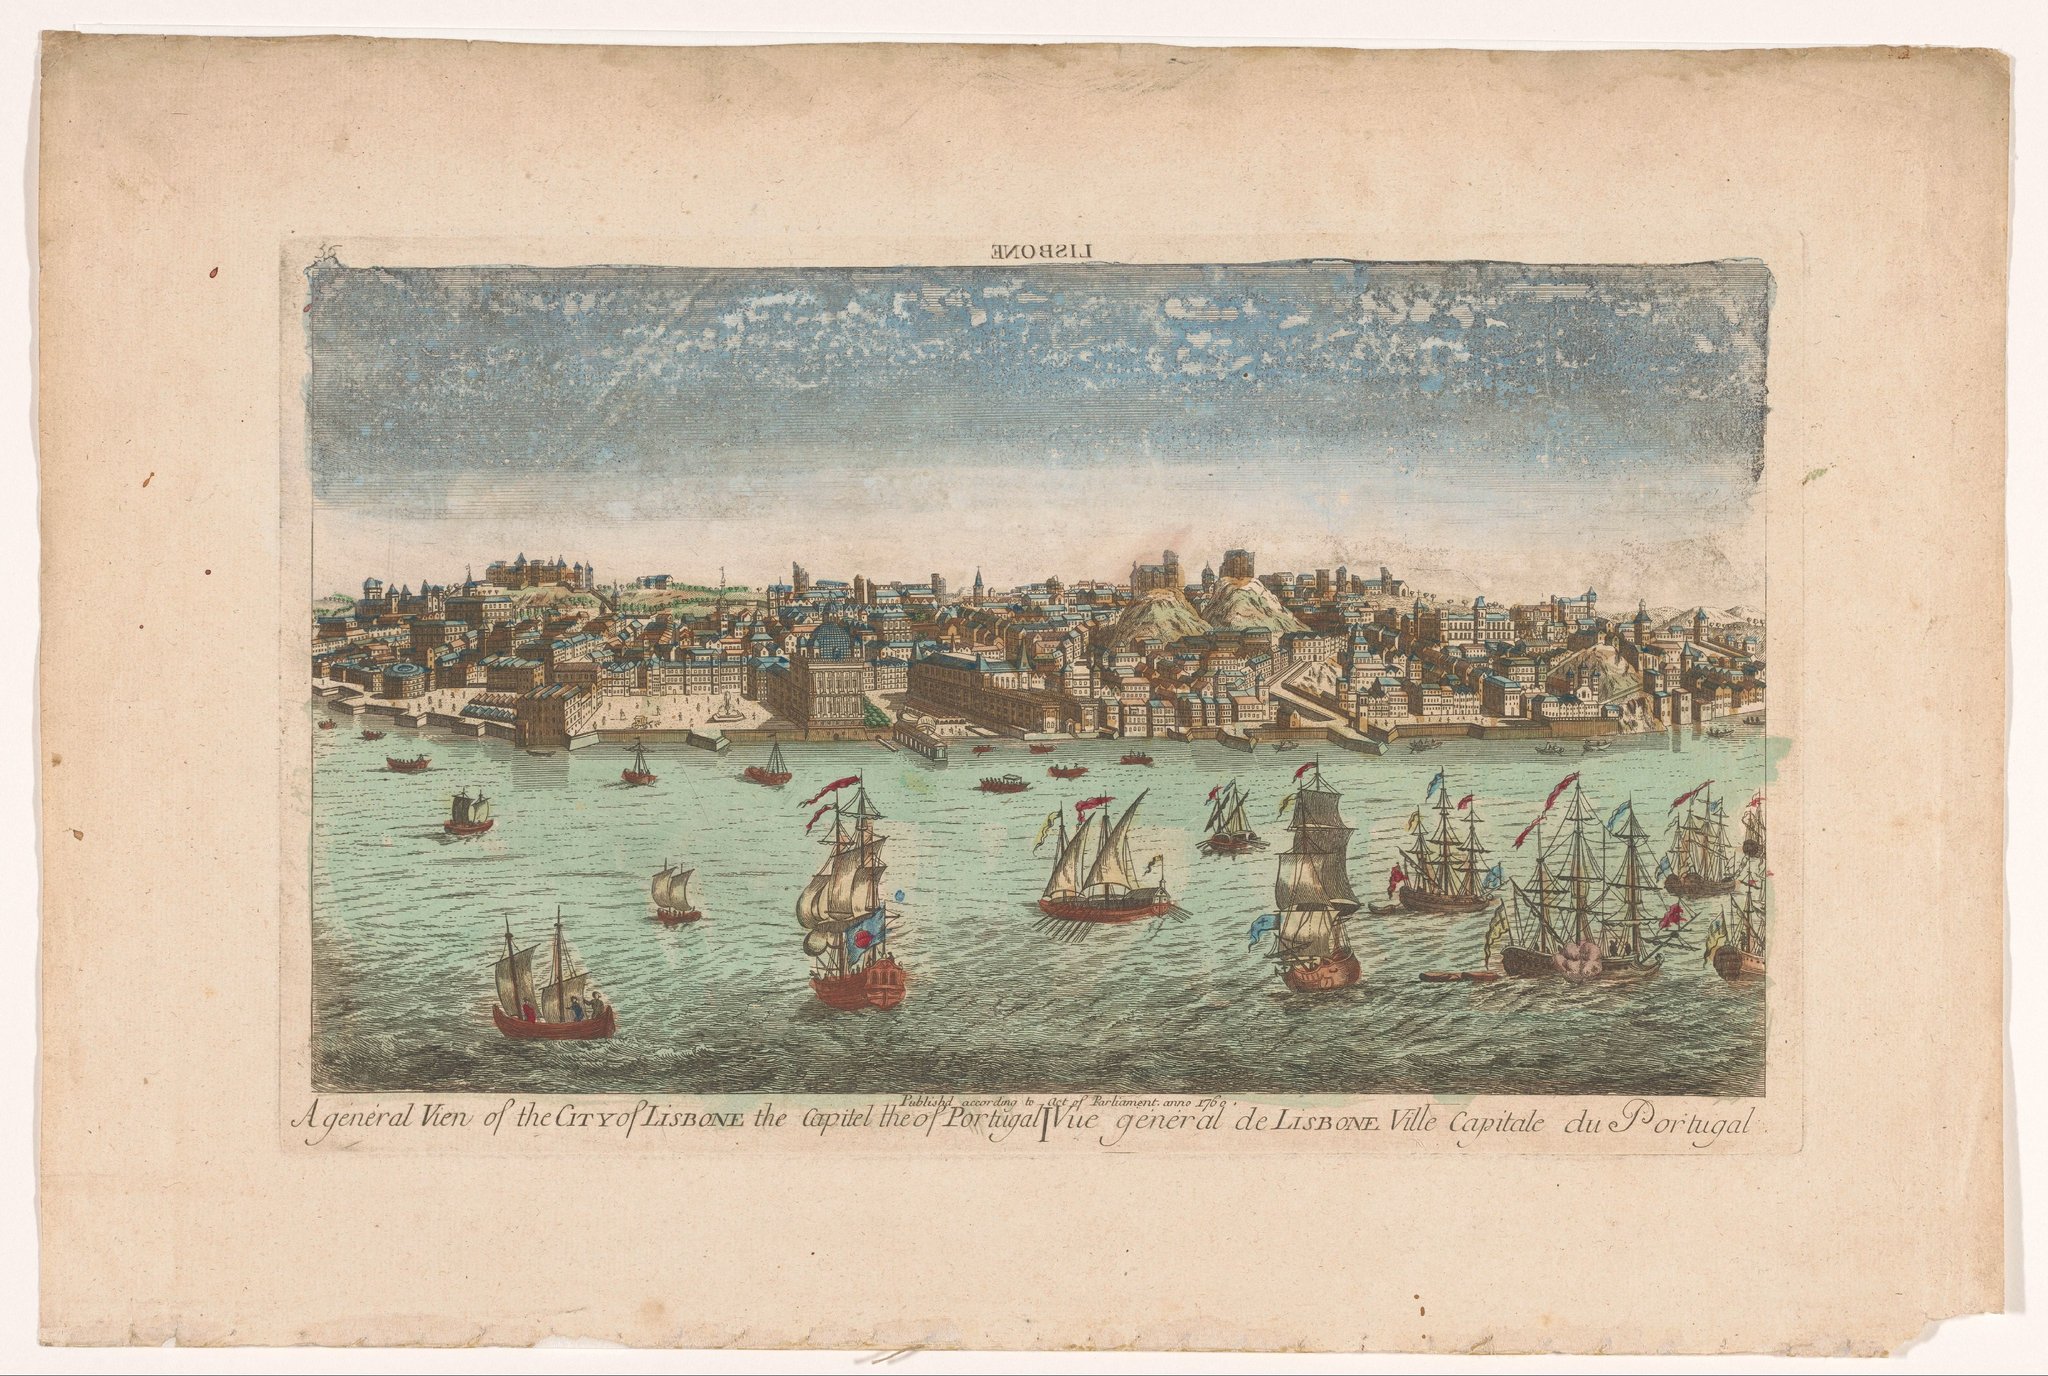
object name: opticaprent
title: Gezicht op de stad Lissabon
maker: Anonymous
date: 1760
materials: paper, watercolor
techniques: brush, etching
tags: sailing-ship, sailing-boat, rowing-boat, canoe, etc., city-view in general; 'veduta' (+ city(-scape) with figures, staffage)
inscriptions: collector's mark: Lugt 2166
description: De datering is mogelijk deels mee gekopieerd.